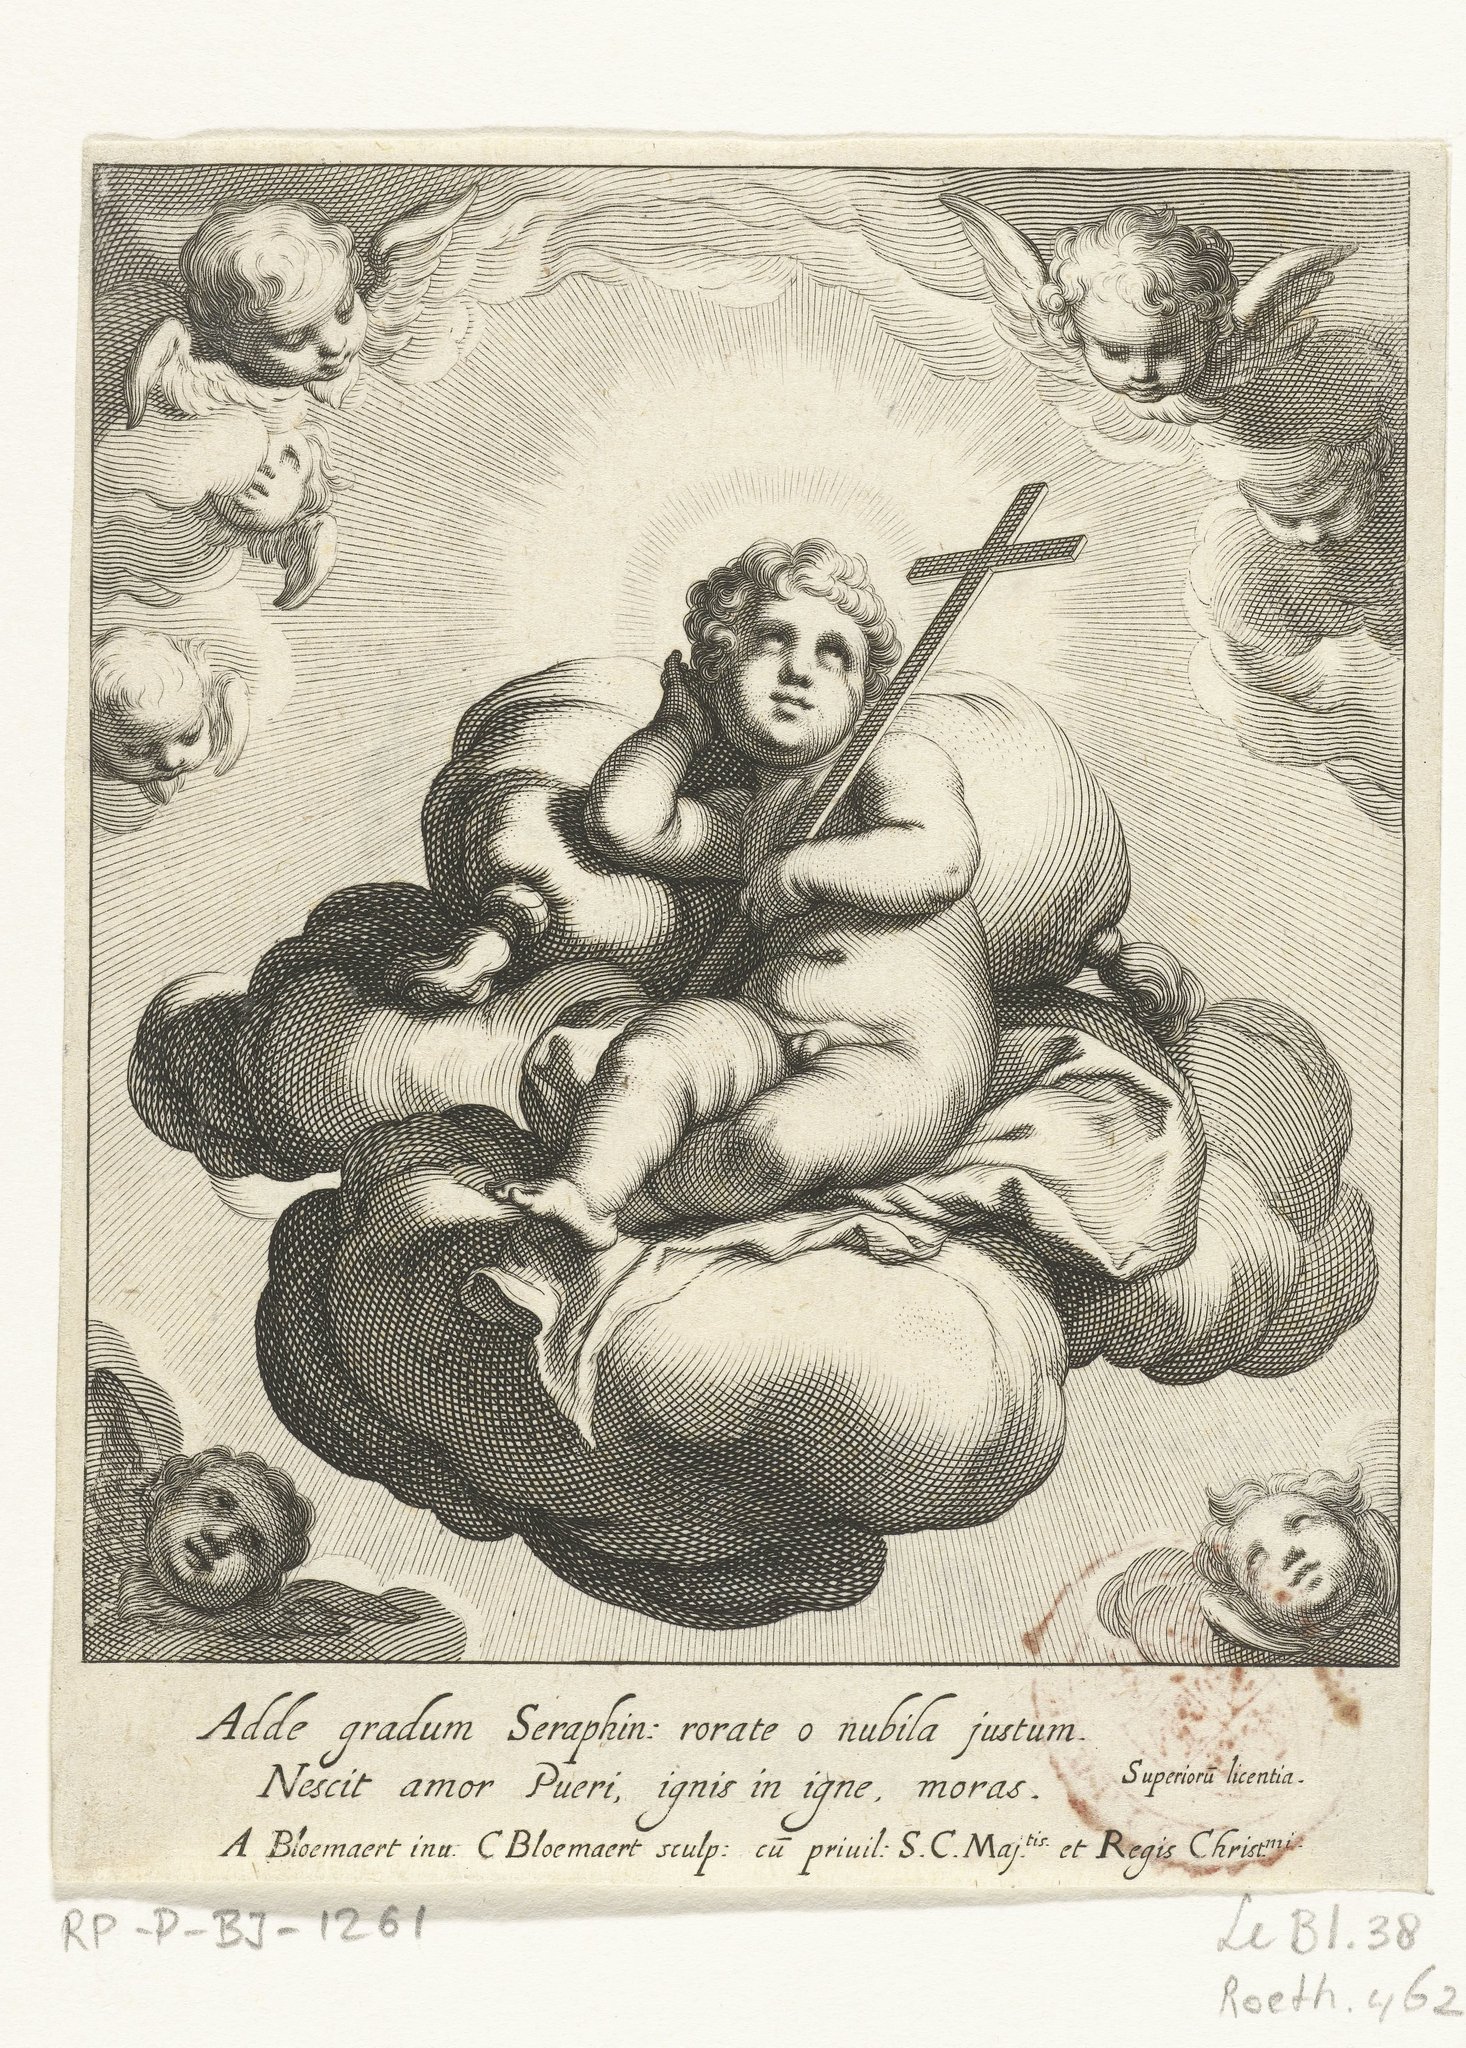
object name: print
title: Christuskind in de wolken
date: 1630-1633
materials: paper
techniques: engraving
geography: paris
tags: christ-child (with attributes)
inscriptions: collector's mark: Lugt 240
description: Het Christuskind zit op de wolken, omgeven door cherubijnen, en richt de ogen naar het kruis dat hij in de linkerhand draagt.